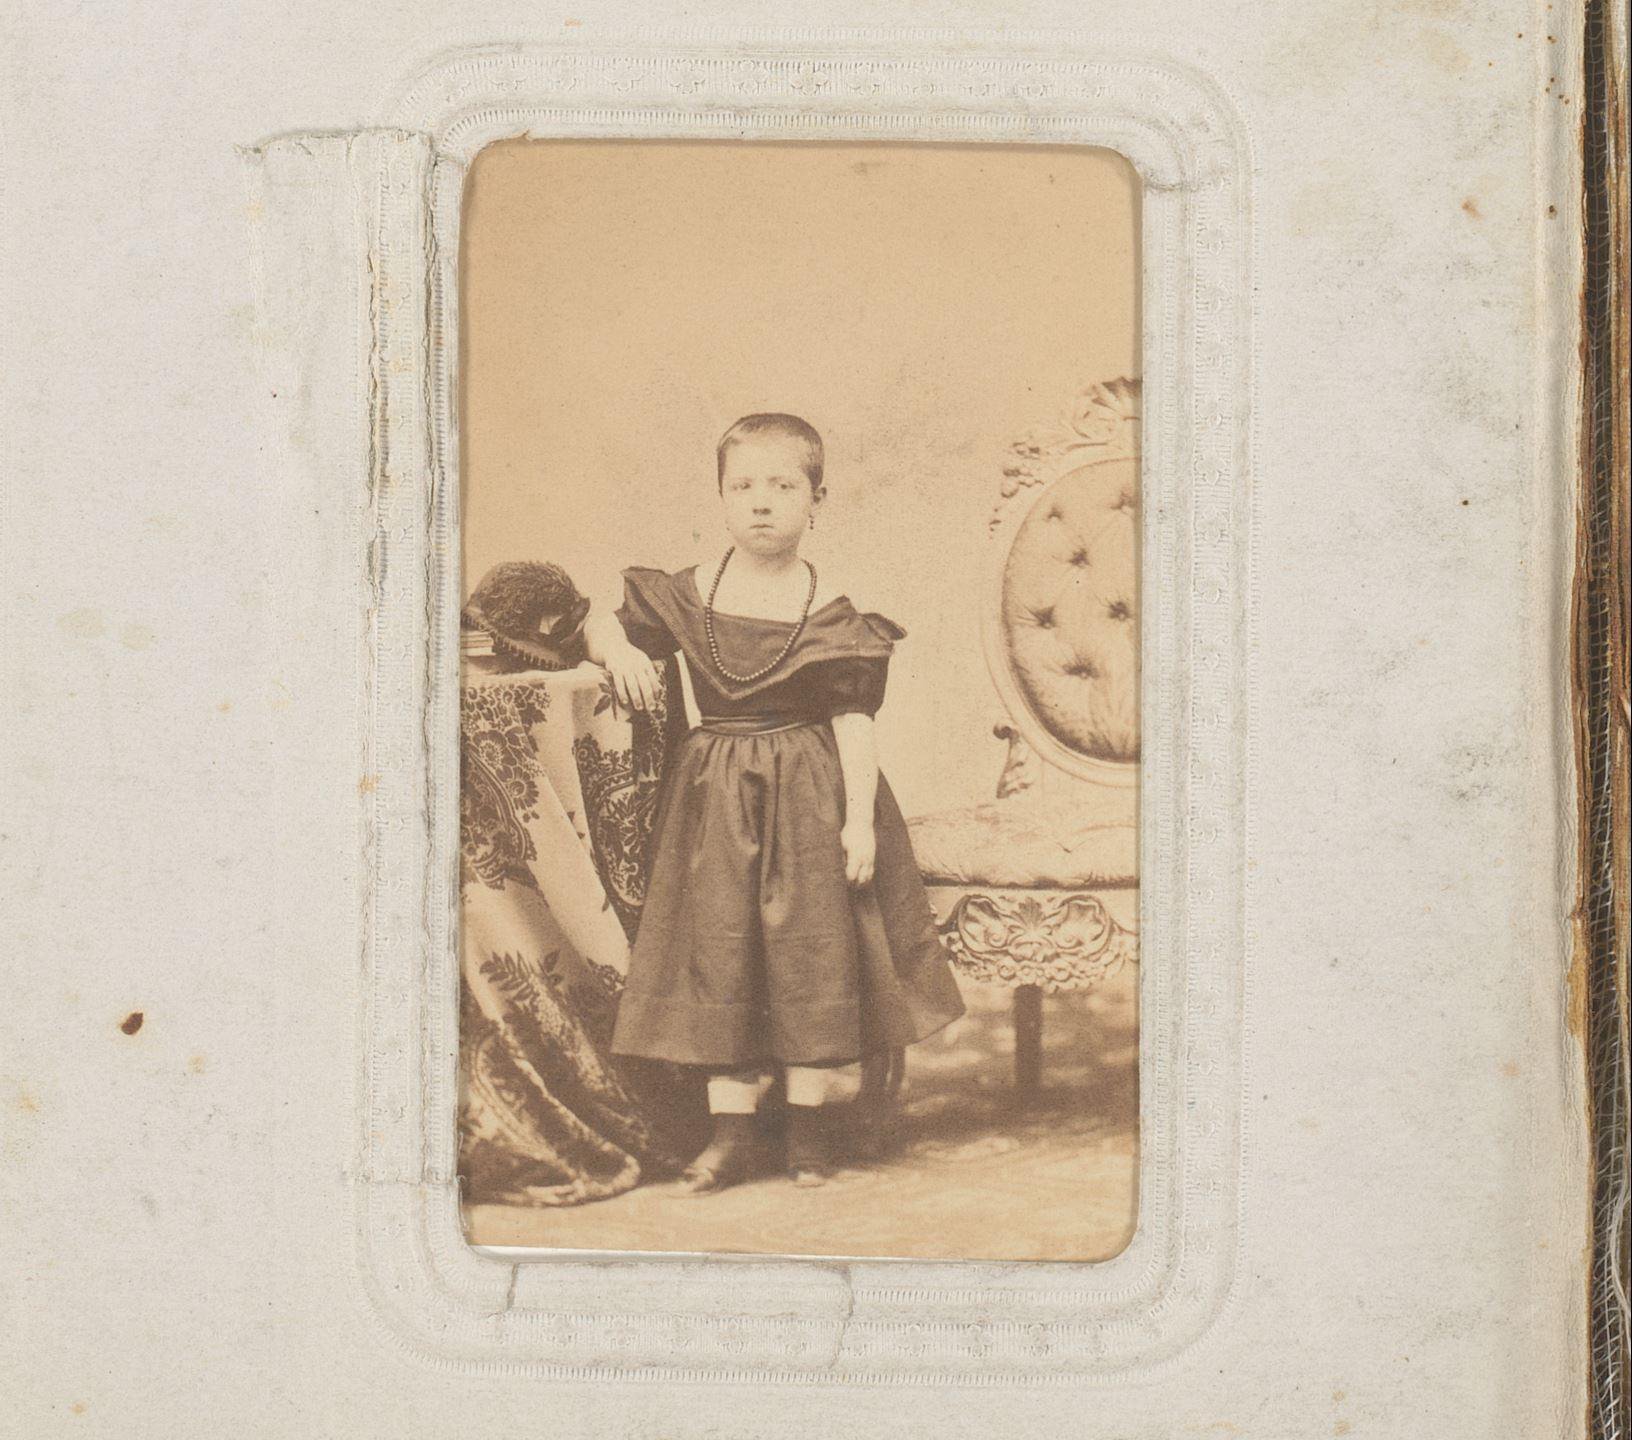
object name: photograph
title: Portret van een meisje met ketting en muts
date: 1860-1890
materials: cardboard, photographic support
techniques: albumen print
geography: valencia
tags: girl (child between toddler and youth), head-gear: hat, necklace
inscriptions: inscription: ‘Ludovisi/ y su señora/ Fotógrafos Romanos/ Cabelleros, 24/ Valencia’